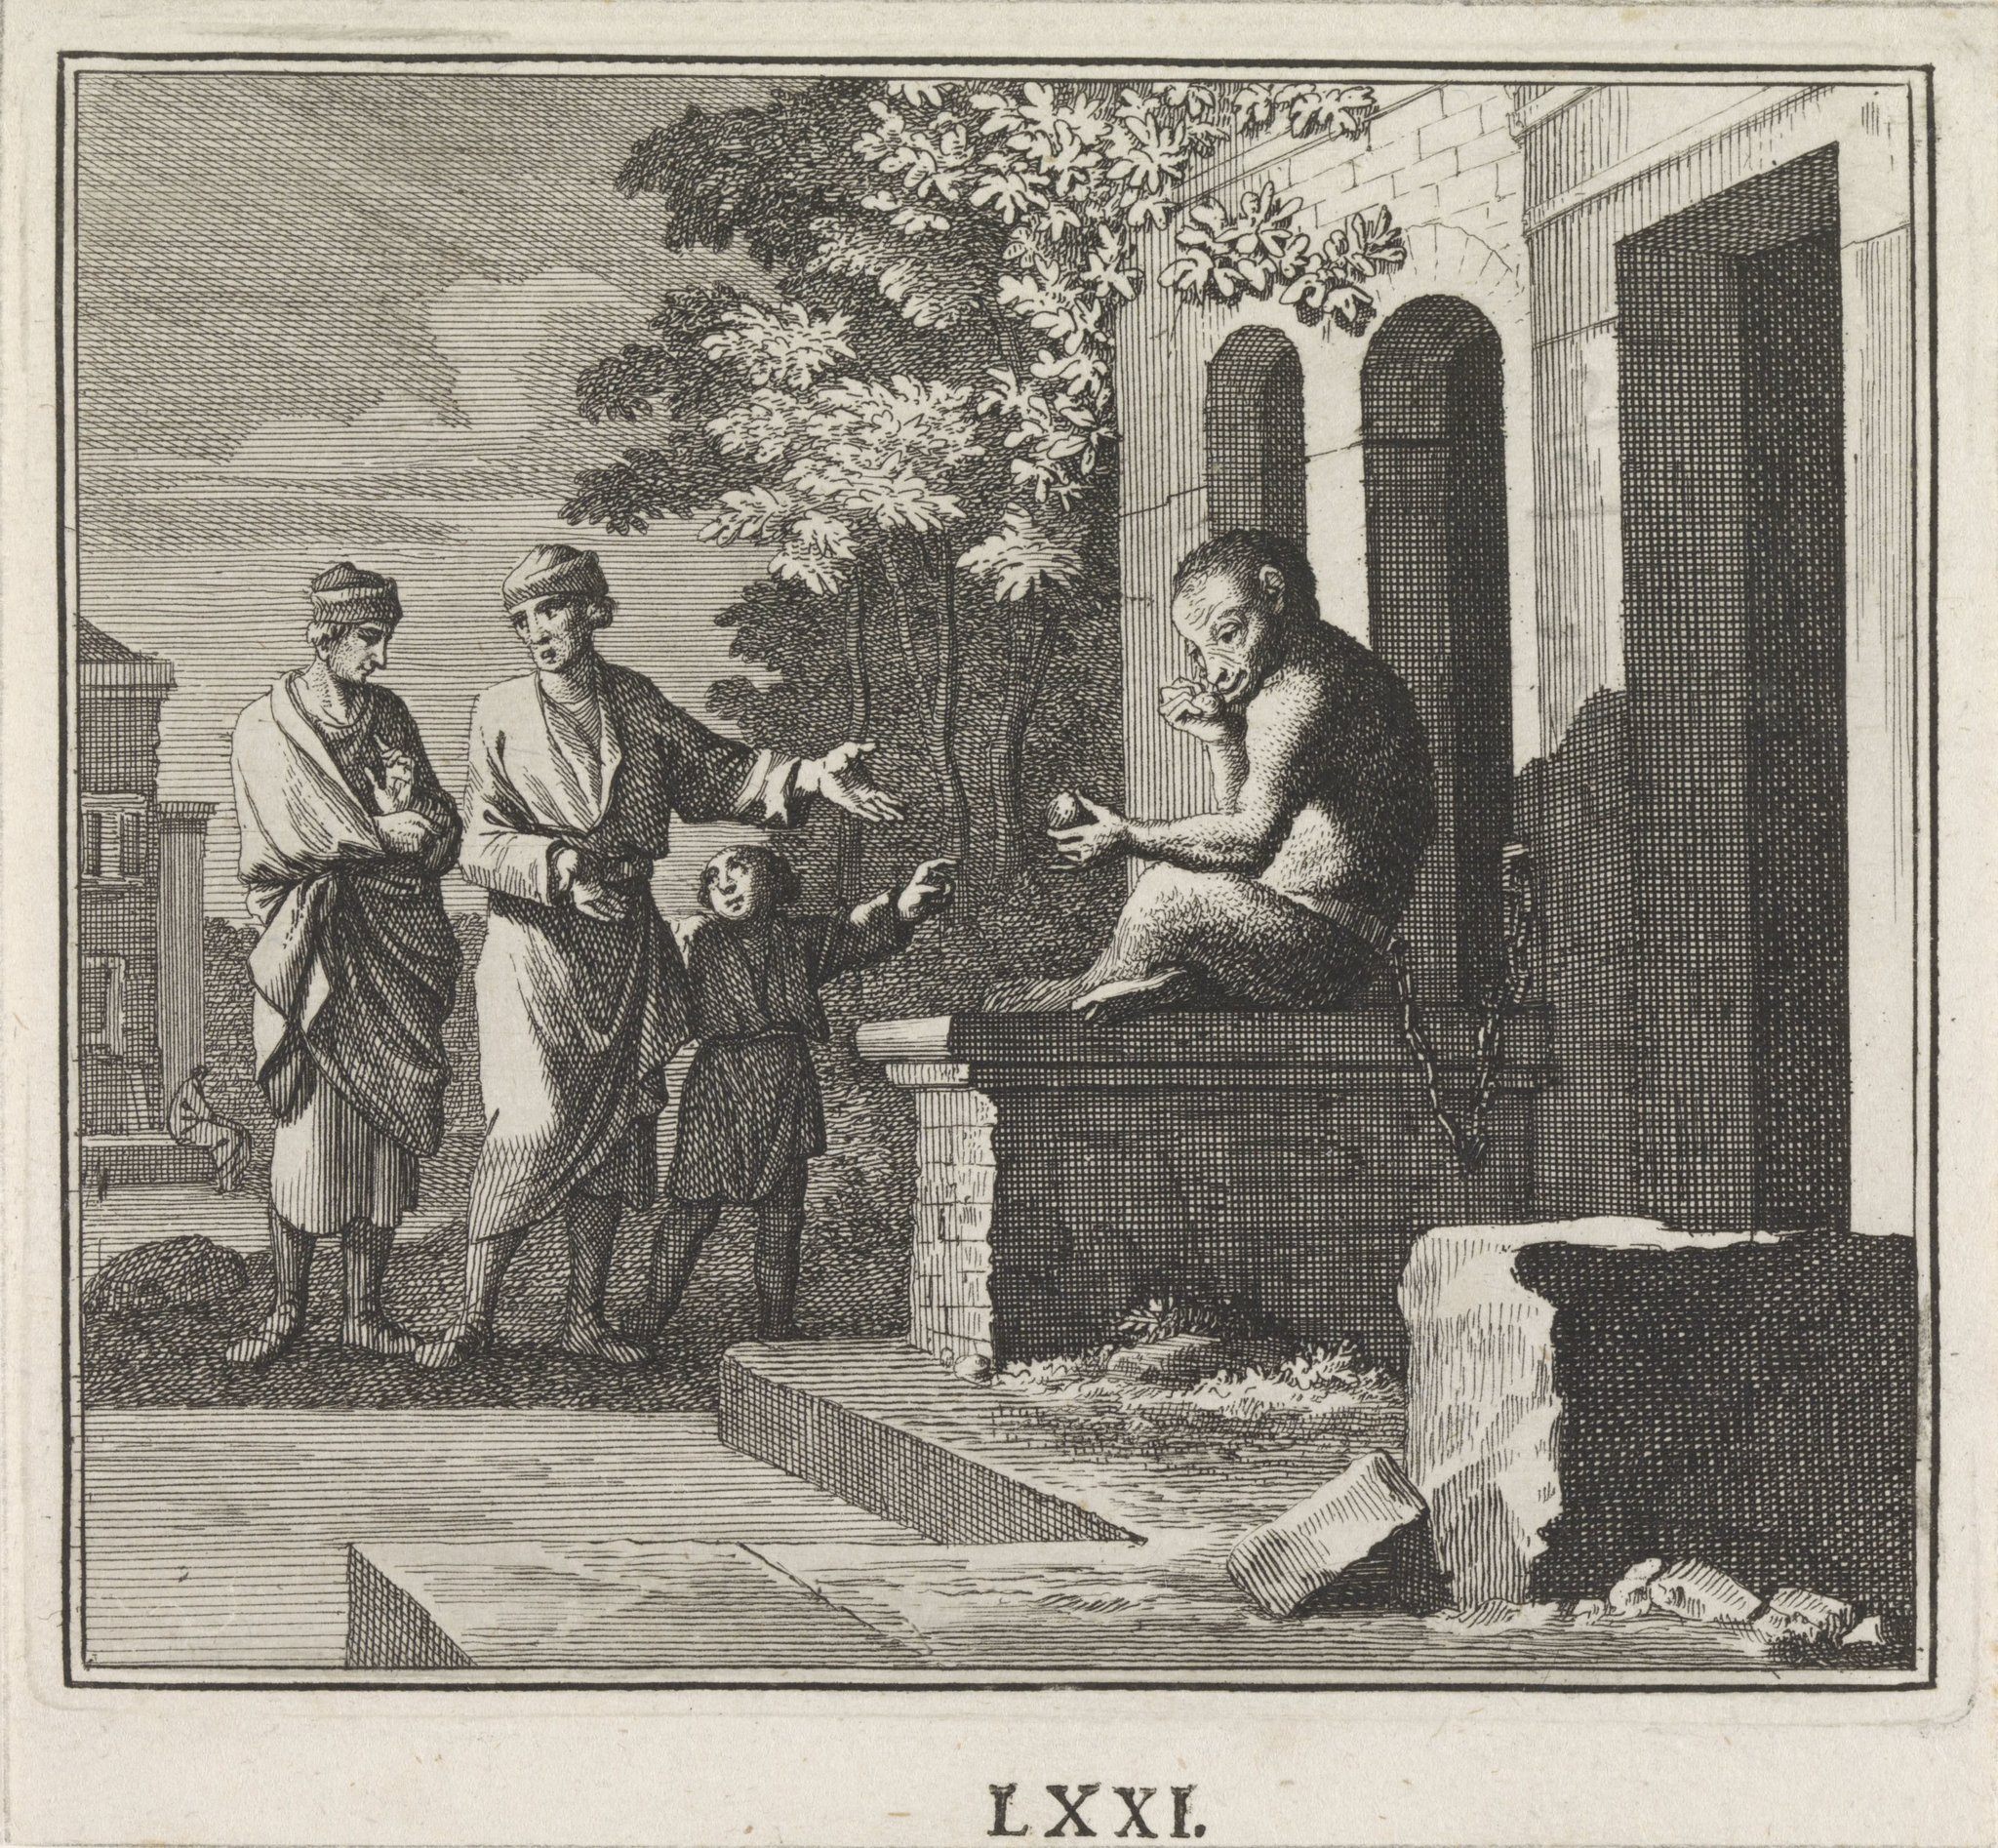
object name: print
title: Embleem: aap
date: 1695-1705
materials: paper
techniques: etching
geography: nuremberg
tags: monkeys, apes, street, abstract ideas and concepts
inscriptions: collector's mark: Lugt 2228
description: Boekillustratie voor Weigel, Christoph. Ethica Naturalis seu Documenta Moralia e Variis rerum Naturalium proprietatibus Virtutum Vitiorumq symbolicis imaginibus collecta. Neurenberg: Christoph Weigel: c. 1700.